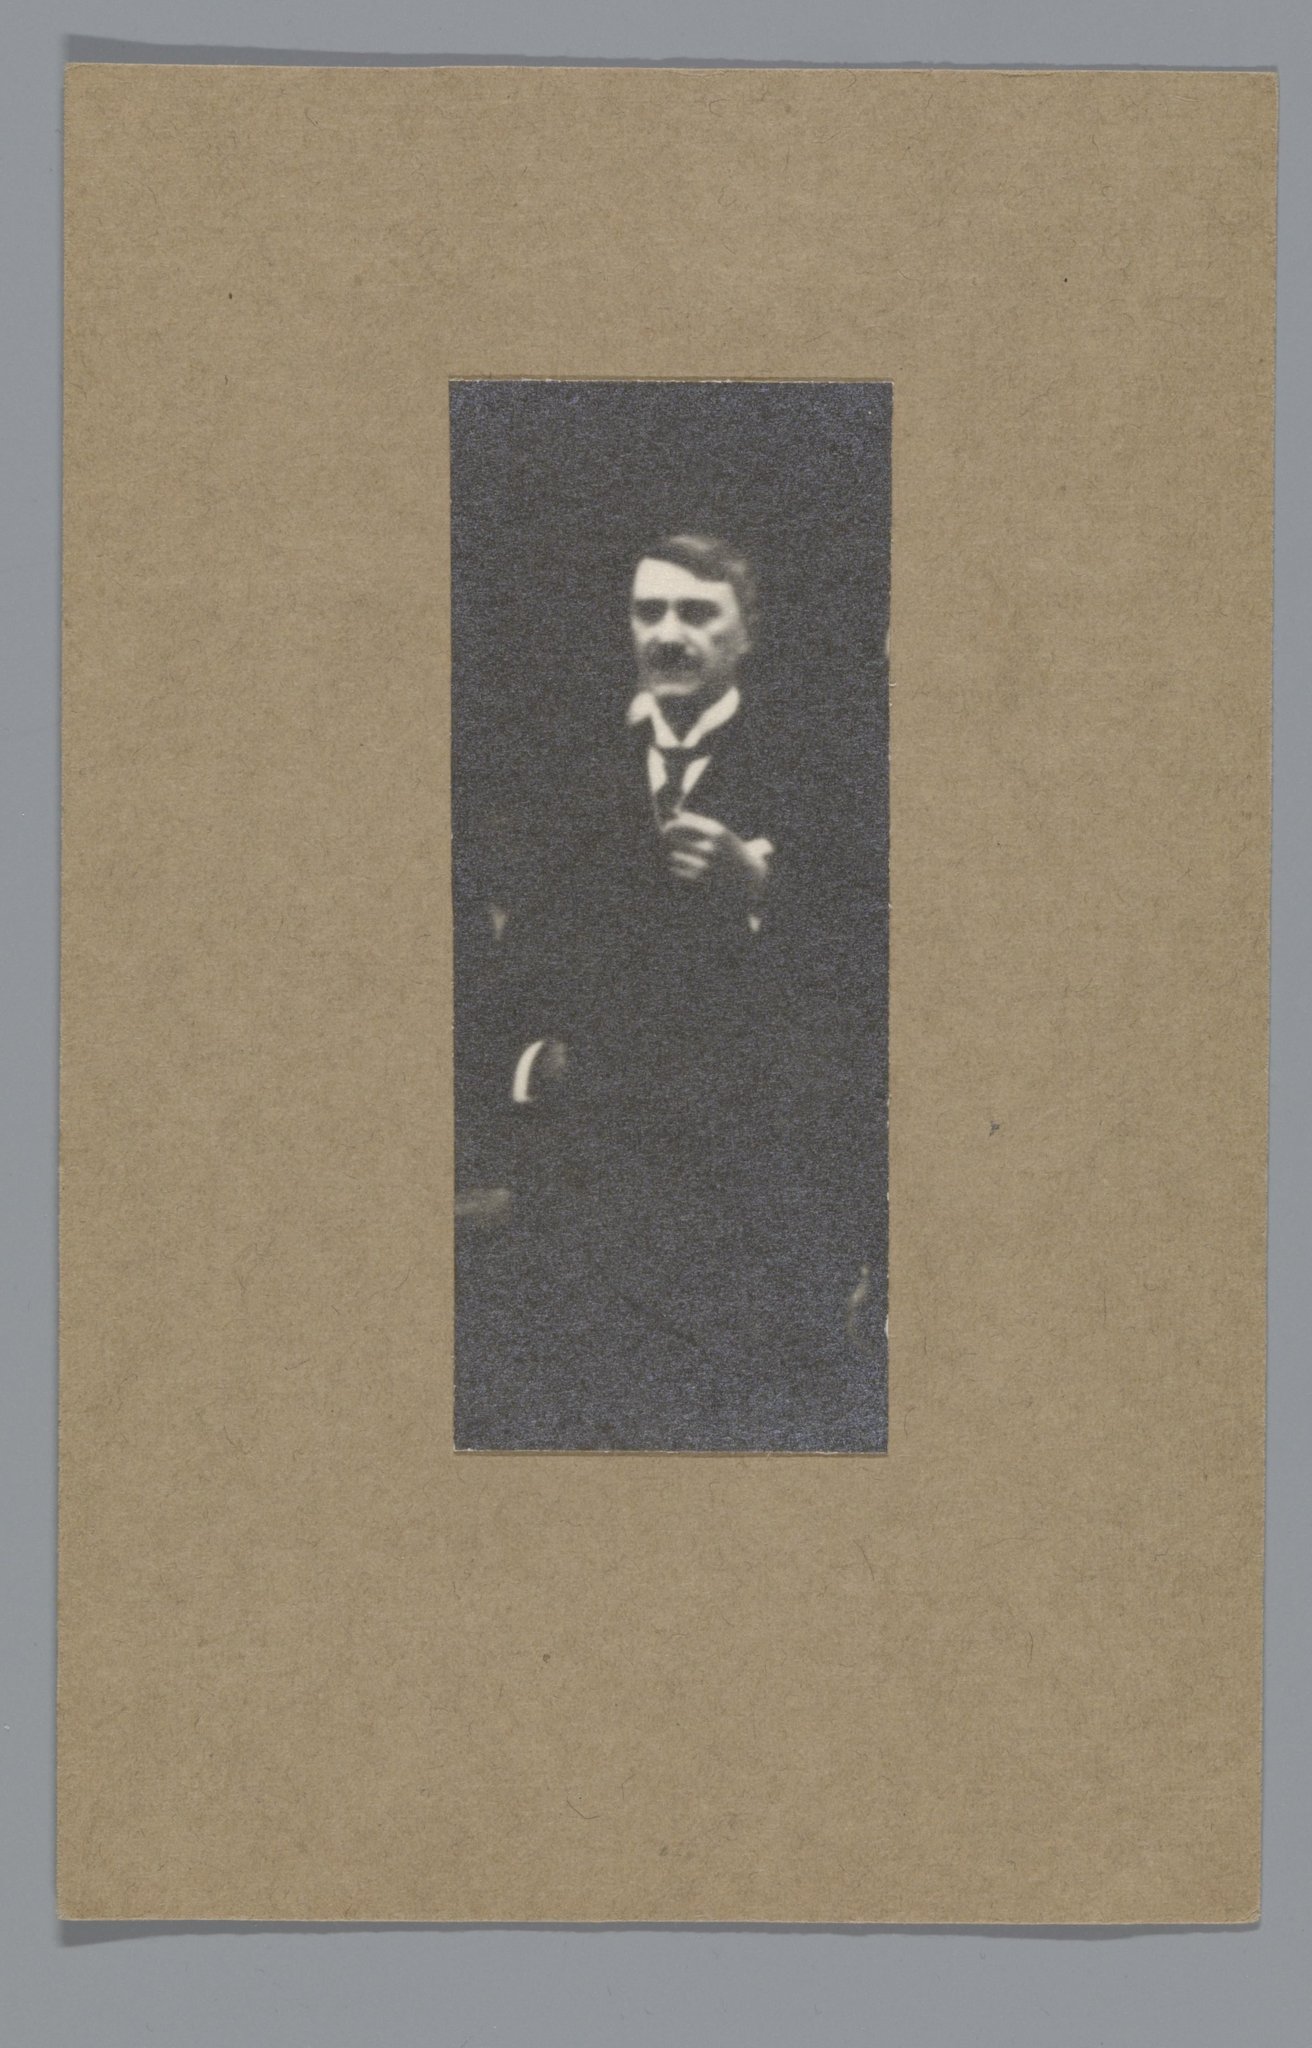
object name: photograph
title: Willem Witsen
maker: Anonymous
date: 1860-1915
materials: paper, photographic support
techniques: gelatin silver print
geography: amsterdam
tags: amsterdam, painter, print maker, draughtsman, willem witsen